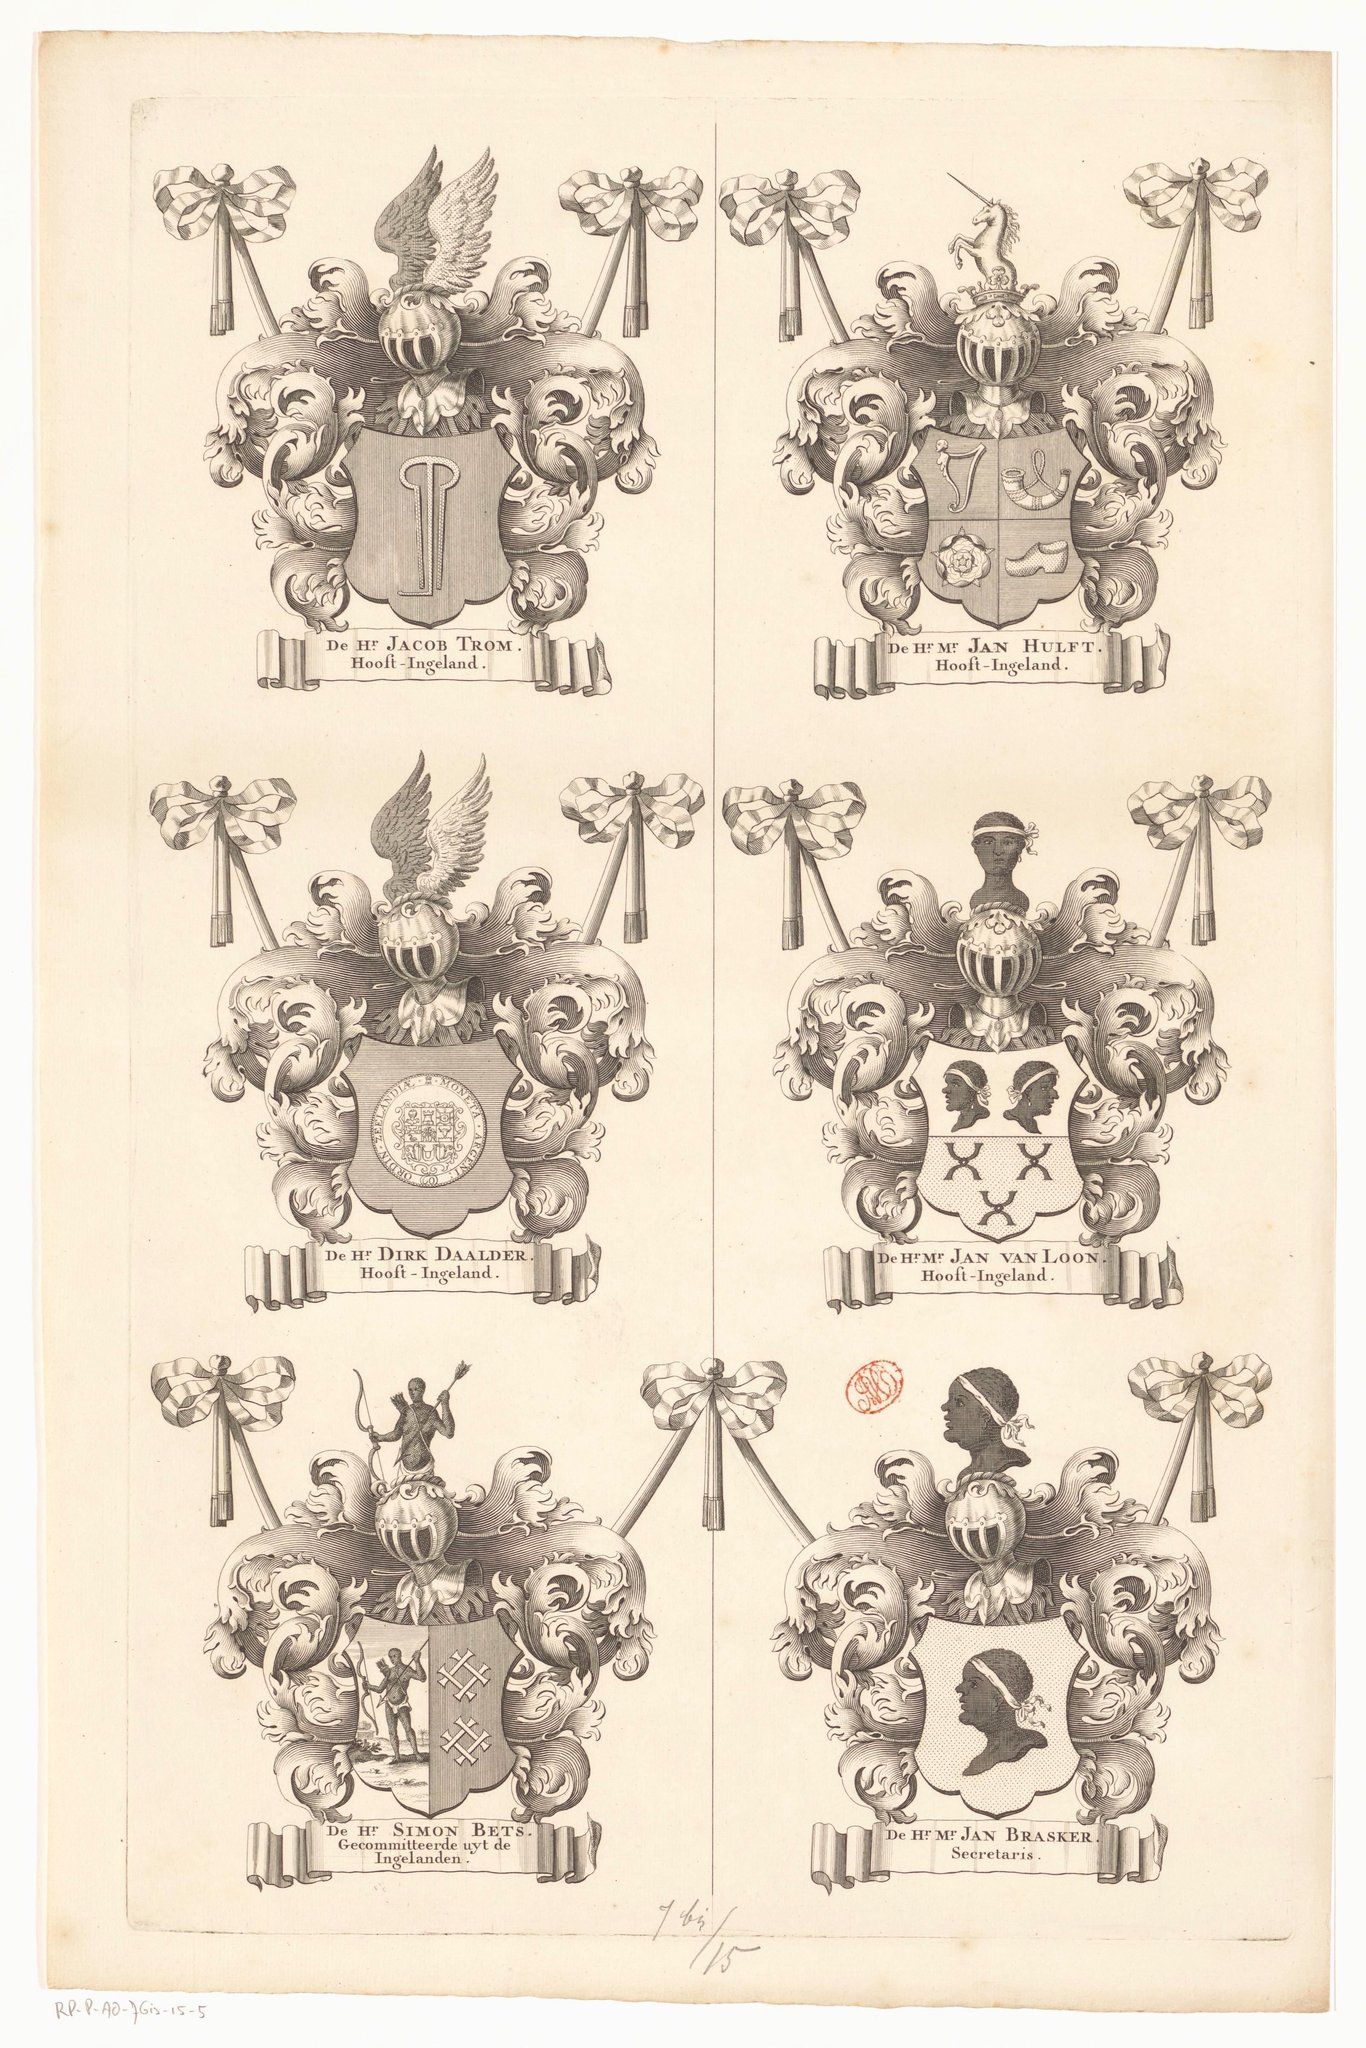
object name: print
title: De Purmer bedyckt inde jaare M.D.C.XVIII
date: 1683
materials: paper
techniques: engraving, etching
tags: armorial bearing, heraldry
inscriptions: collector's mark: Lugt 195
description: Blad met twee stroken voor een wapenrand die hoort bij een kaart van de Purmer. Op de linkerstrook de wapens van twee hoofdingelanden en een gecommitteerde van de ingelanden. Op de rechterstrook de wapens van twee hoofdingelanden en de secretaris.